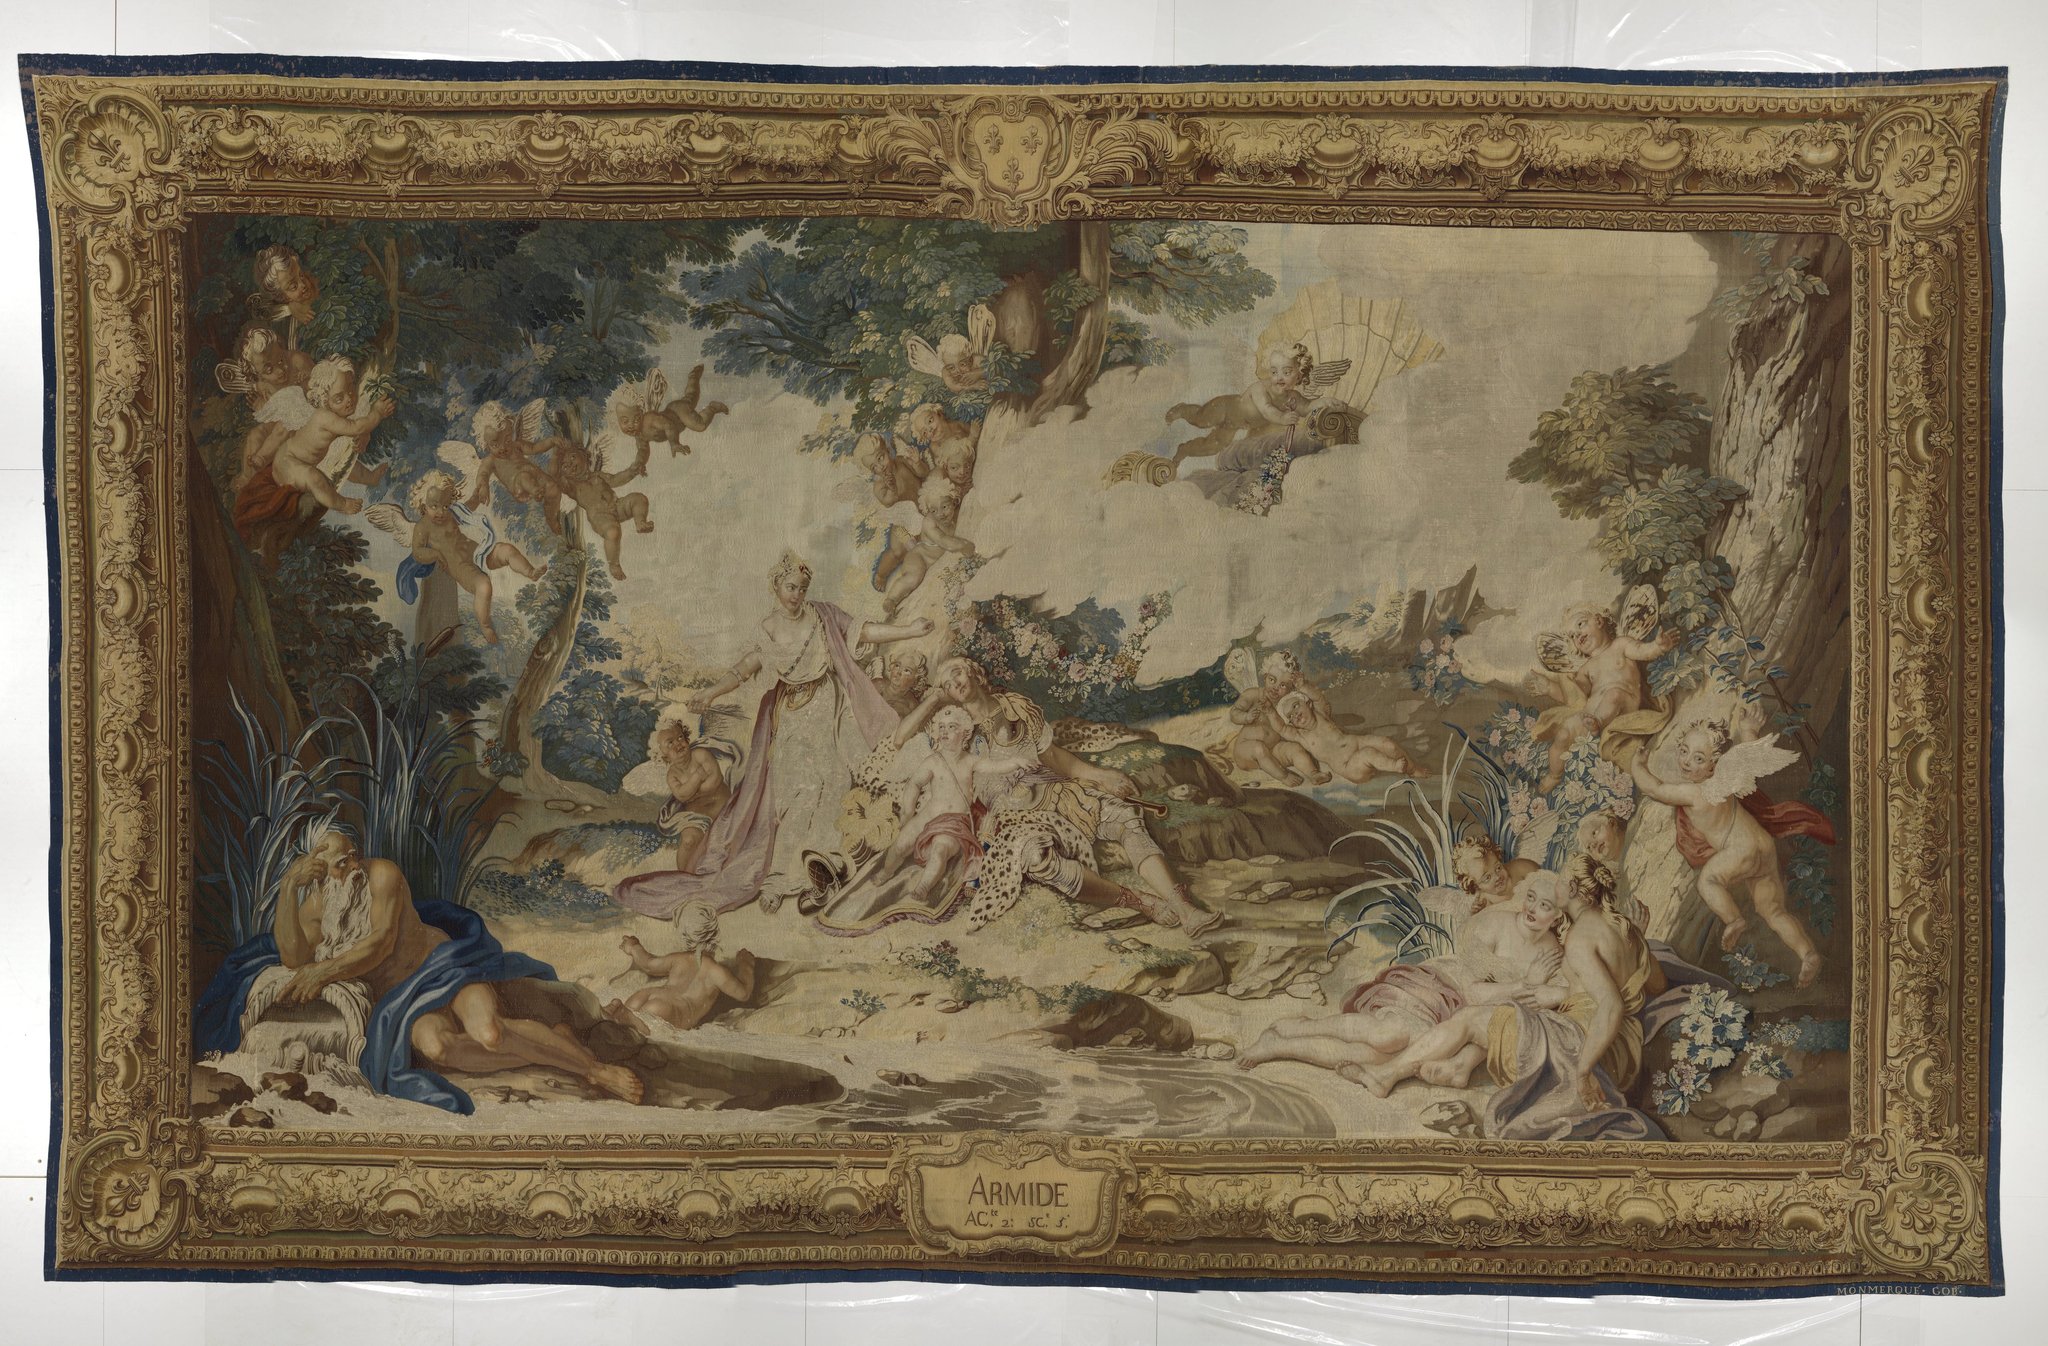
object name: tapestry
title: Fragments d'Opéra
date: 1746-1750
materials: silk, wool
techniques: tapestry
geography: france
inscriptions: signature: ‘MONMERQUÉ.GOBs’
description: Tapestry, one of a set of four with scenes from the opera Rinaldo et Armida (1686) by P. Quinault and J.B. Lully, inspired by the epic poem Gerusalemme Liberata by Torquato Tasso. Wool and silk, tapestry woven. Paris, 1741 - 1749, Manufacture Royale des Gobelins, workshop of Mathieu Monmerqué and Pierre François Cozette. The scene of Armida falling in love with the sleeping Rinaldo is after a design by Charles Coypel, 1741, the borders after one by Pierre Josse Perrot, 1738. Presented by Louis XV to the Spanish ambassador Paul-Gérôme Grimaldi in 1763 Given by the Commissie voor Fotoverkoop, 1955.